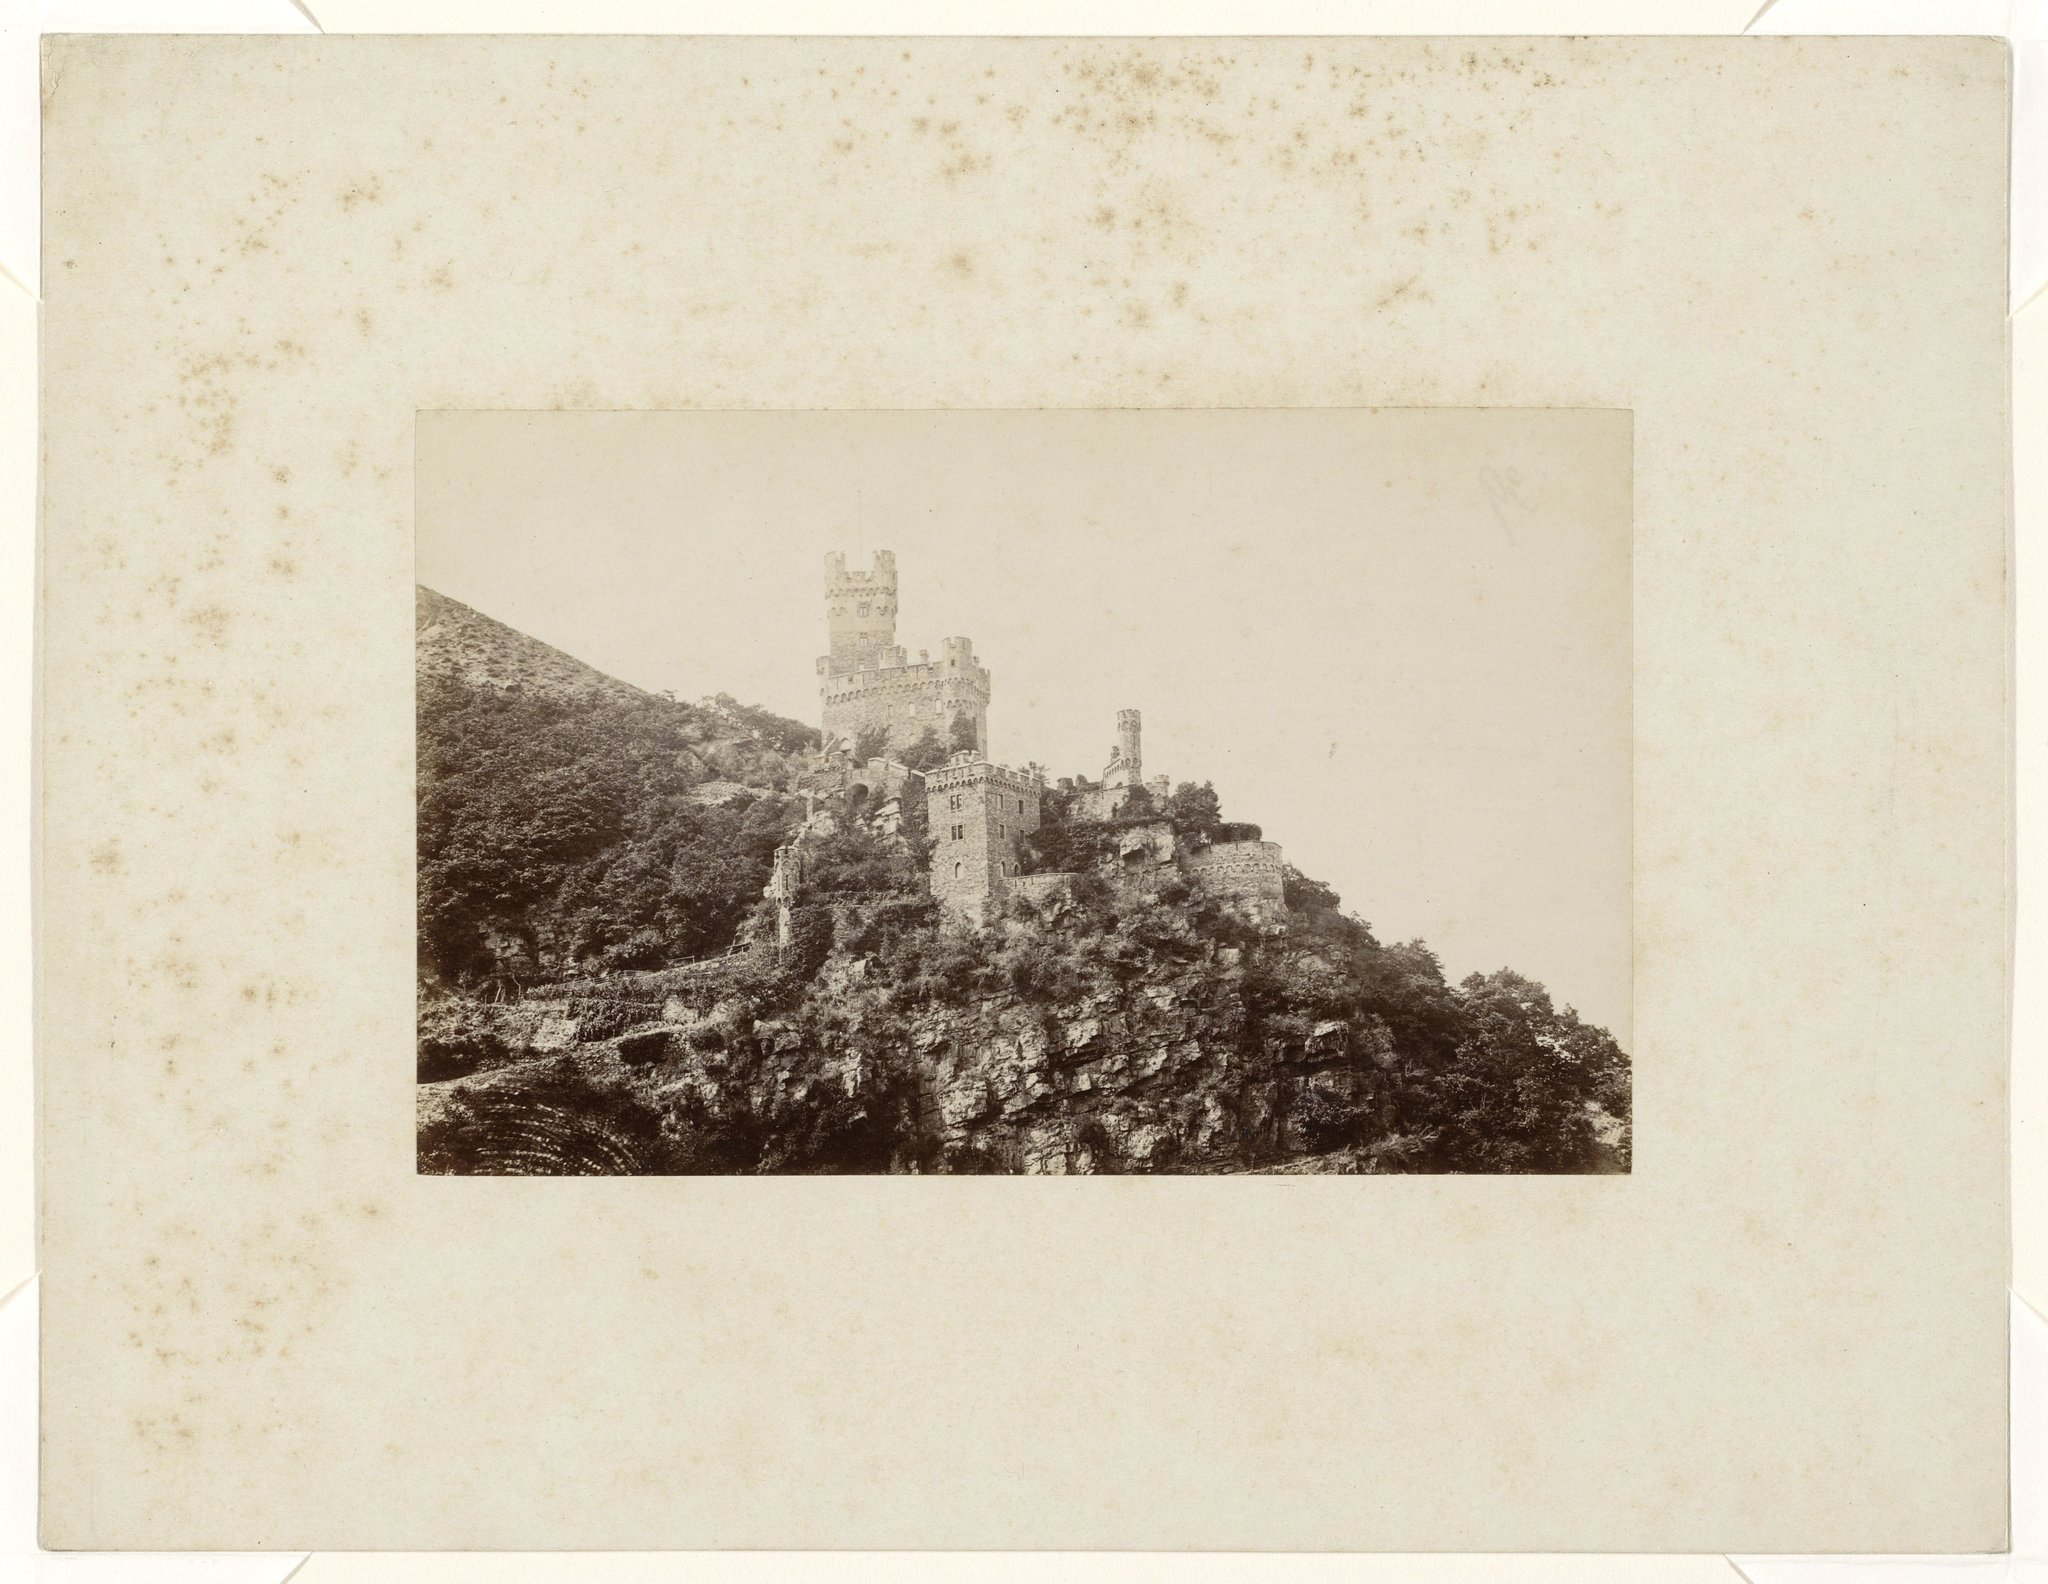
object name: photograph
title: Burcht Sooneck bij Bingen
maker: Anonymous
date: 1883-1890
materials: cardboard, paper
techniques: albumen print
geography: bingen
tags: castle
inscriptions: inscription: ‘29 dinsdag 28 juli/ Sonneck bei Bingen’